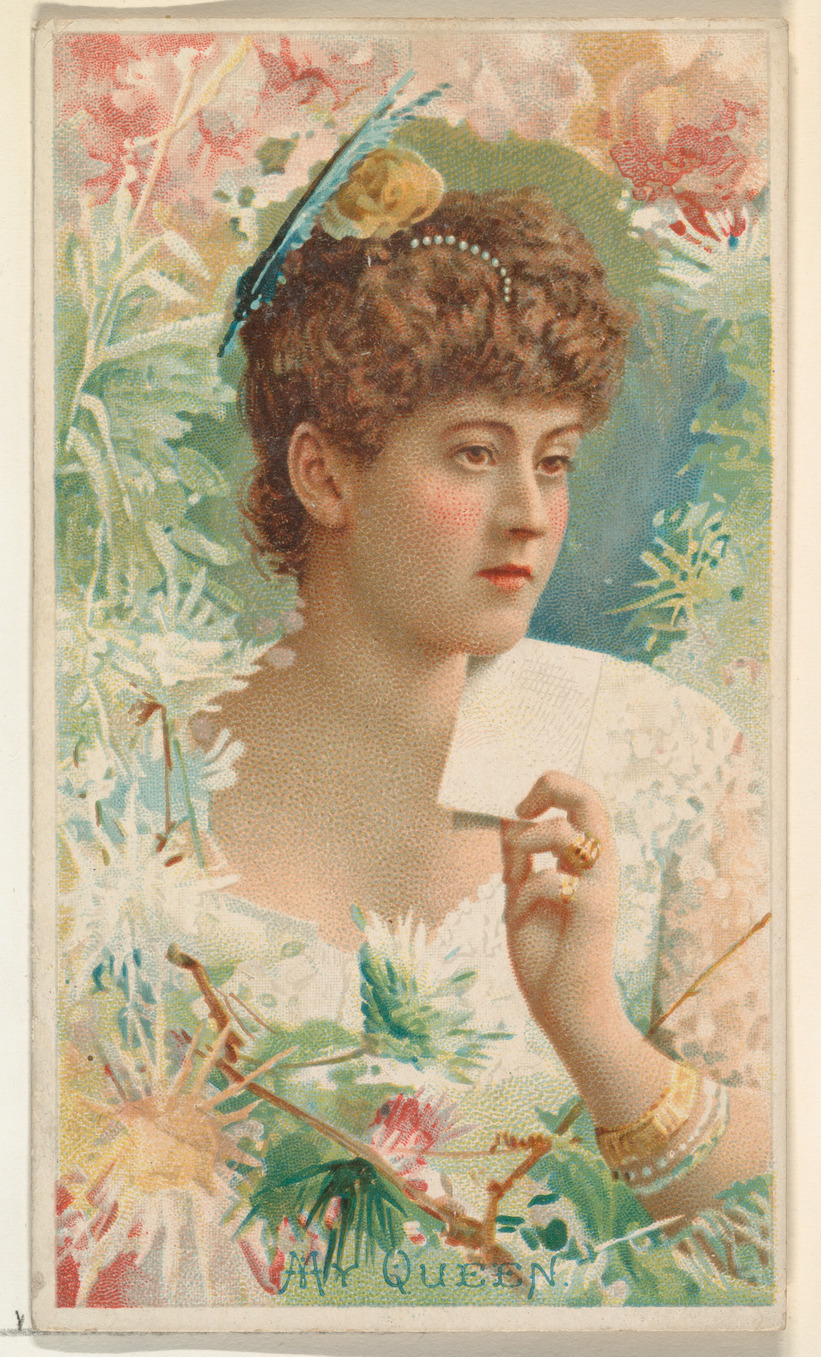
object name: print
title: My Queen, from the Illustrated Songs series (N116) issued by W. Duke, Sons & Co. to promote Honest Long Cut Tobacco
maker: w. duke, sons & co.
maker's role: publisher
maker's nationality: american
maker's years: 1870-1920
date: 1893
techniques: color lithograph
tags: women